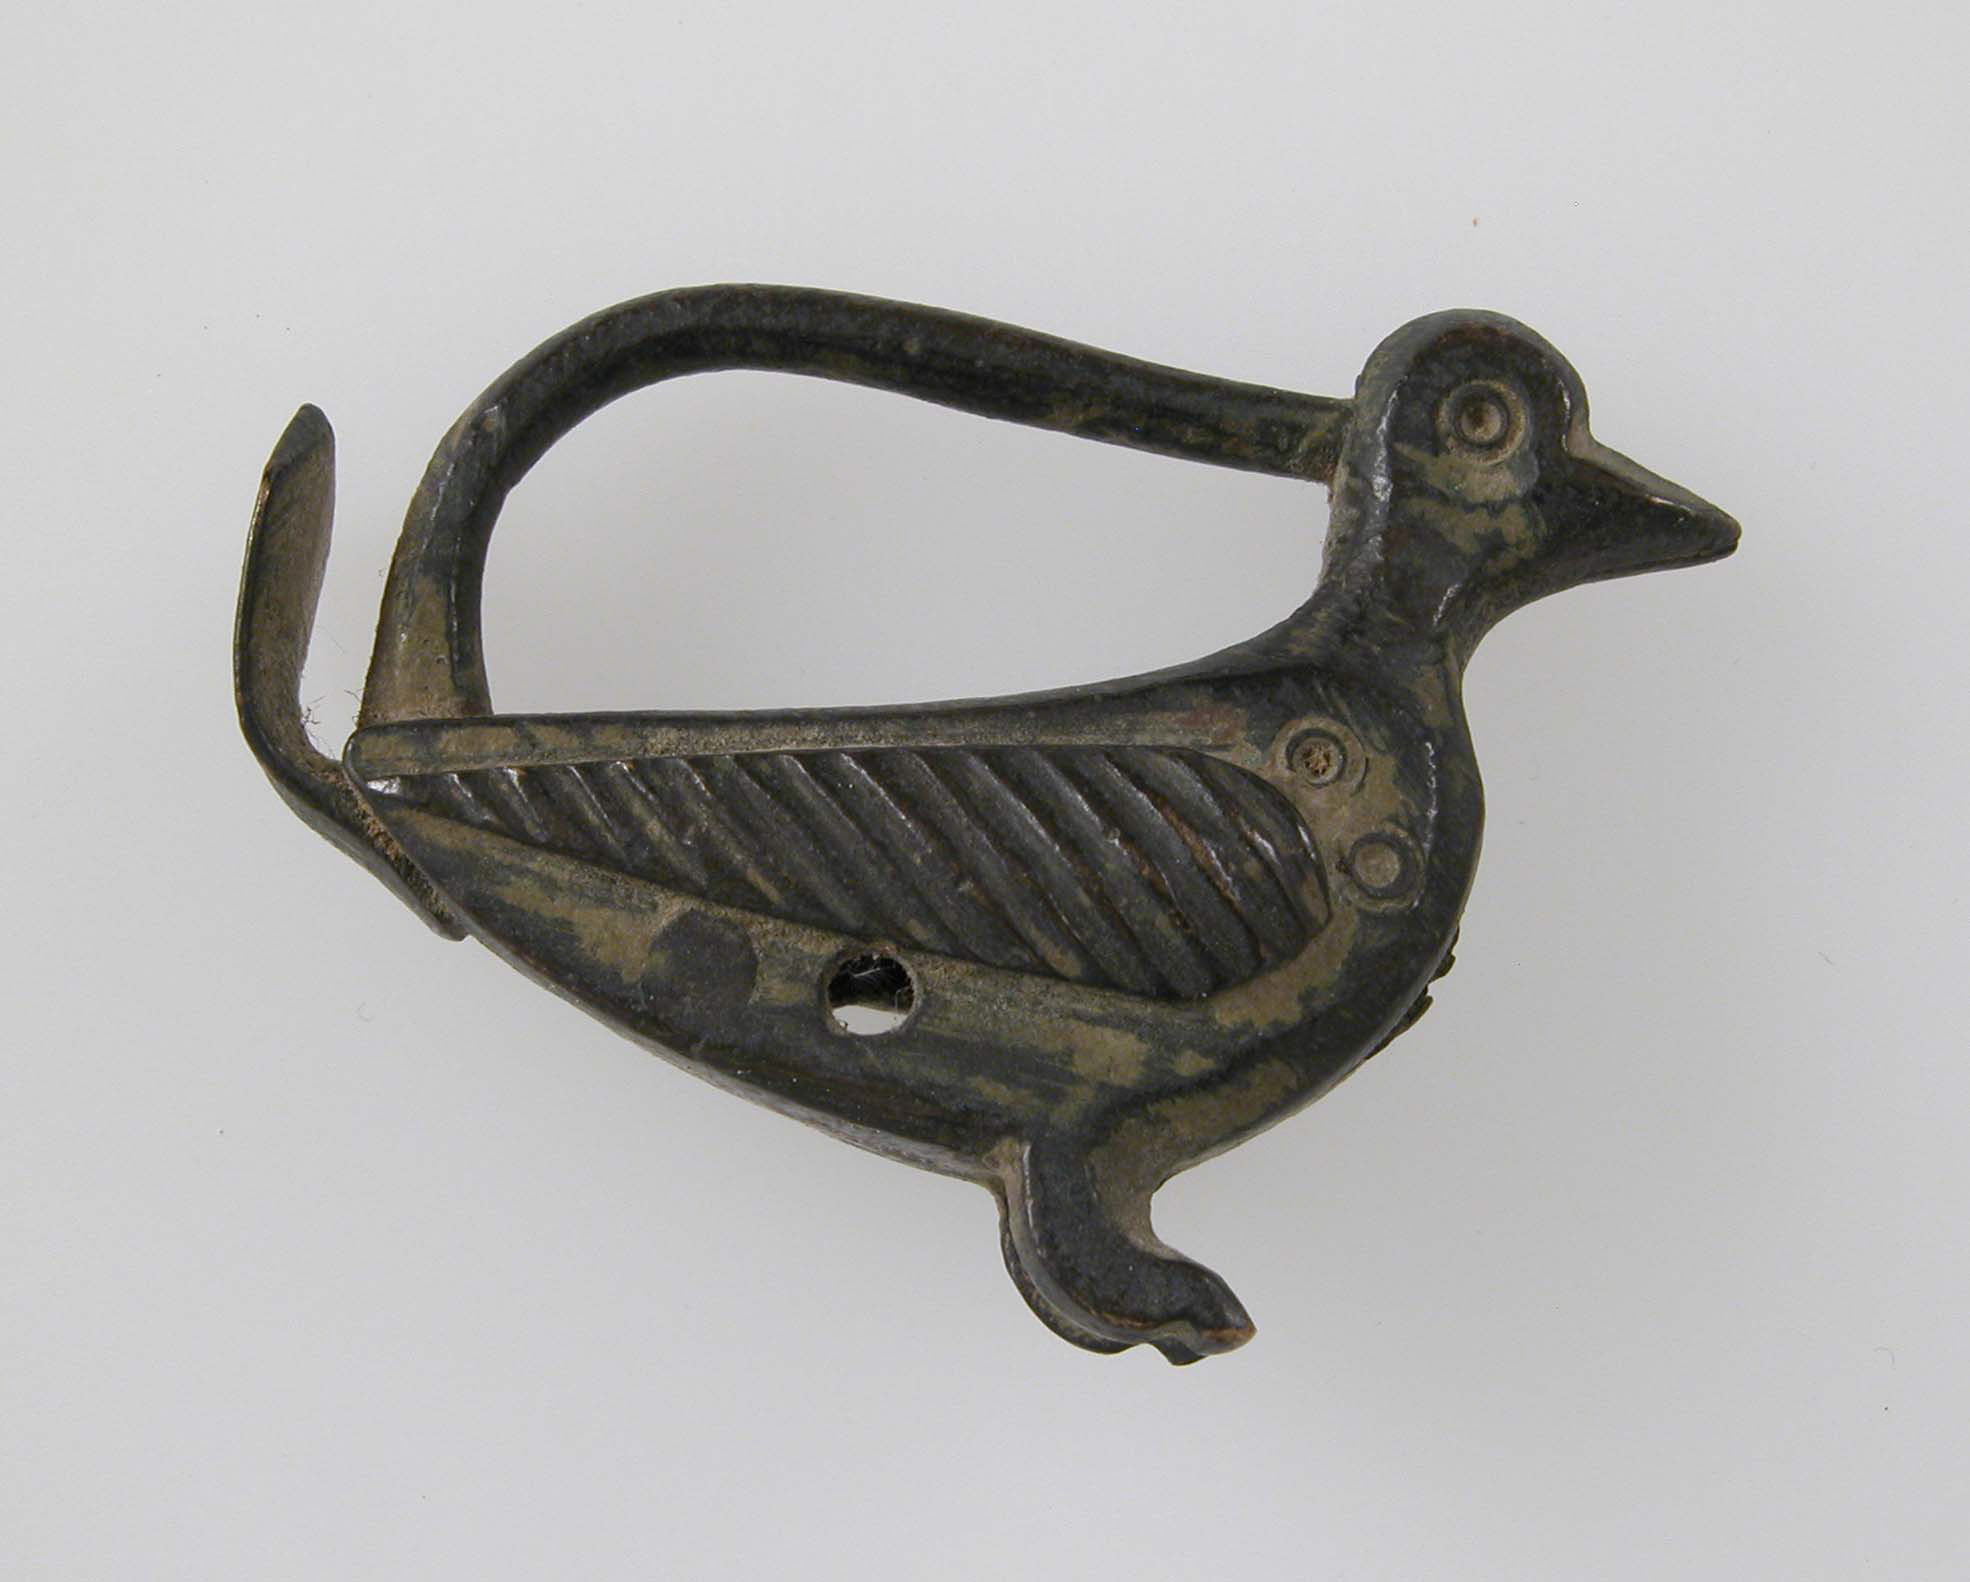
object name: lock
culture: byzantine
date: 1001-1100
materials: copper alloy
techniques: casting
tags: birds